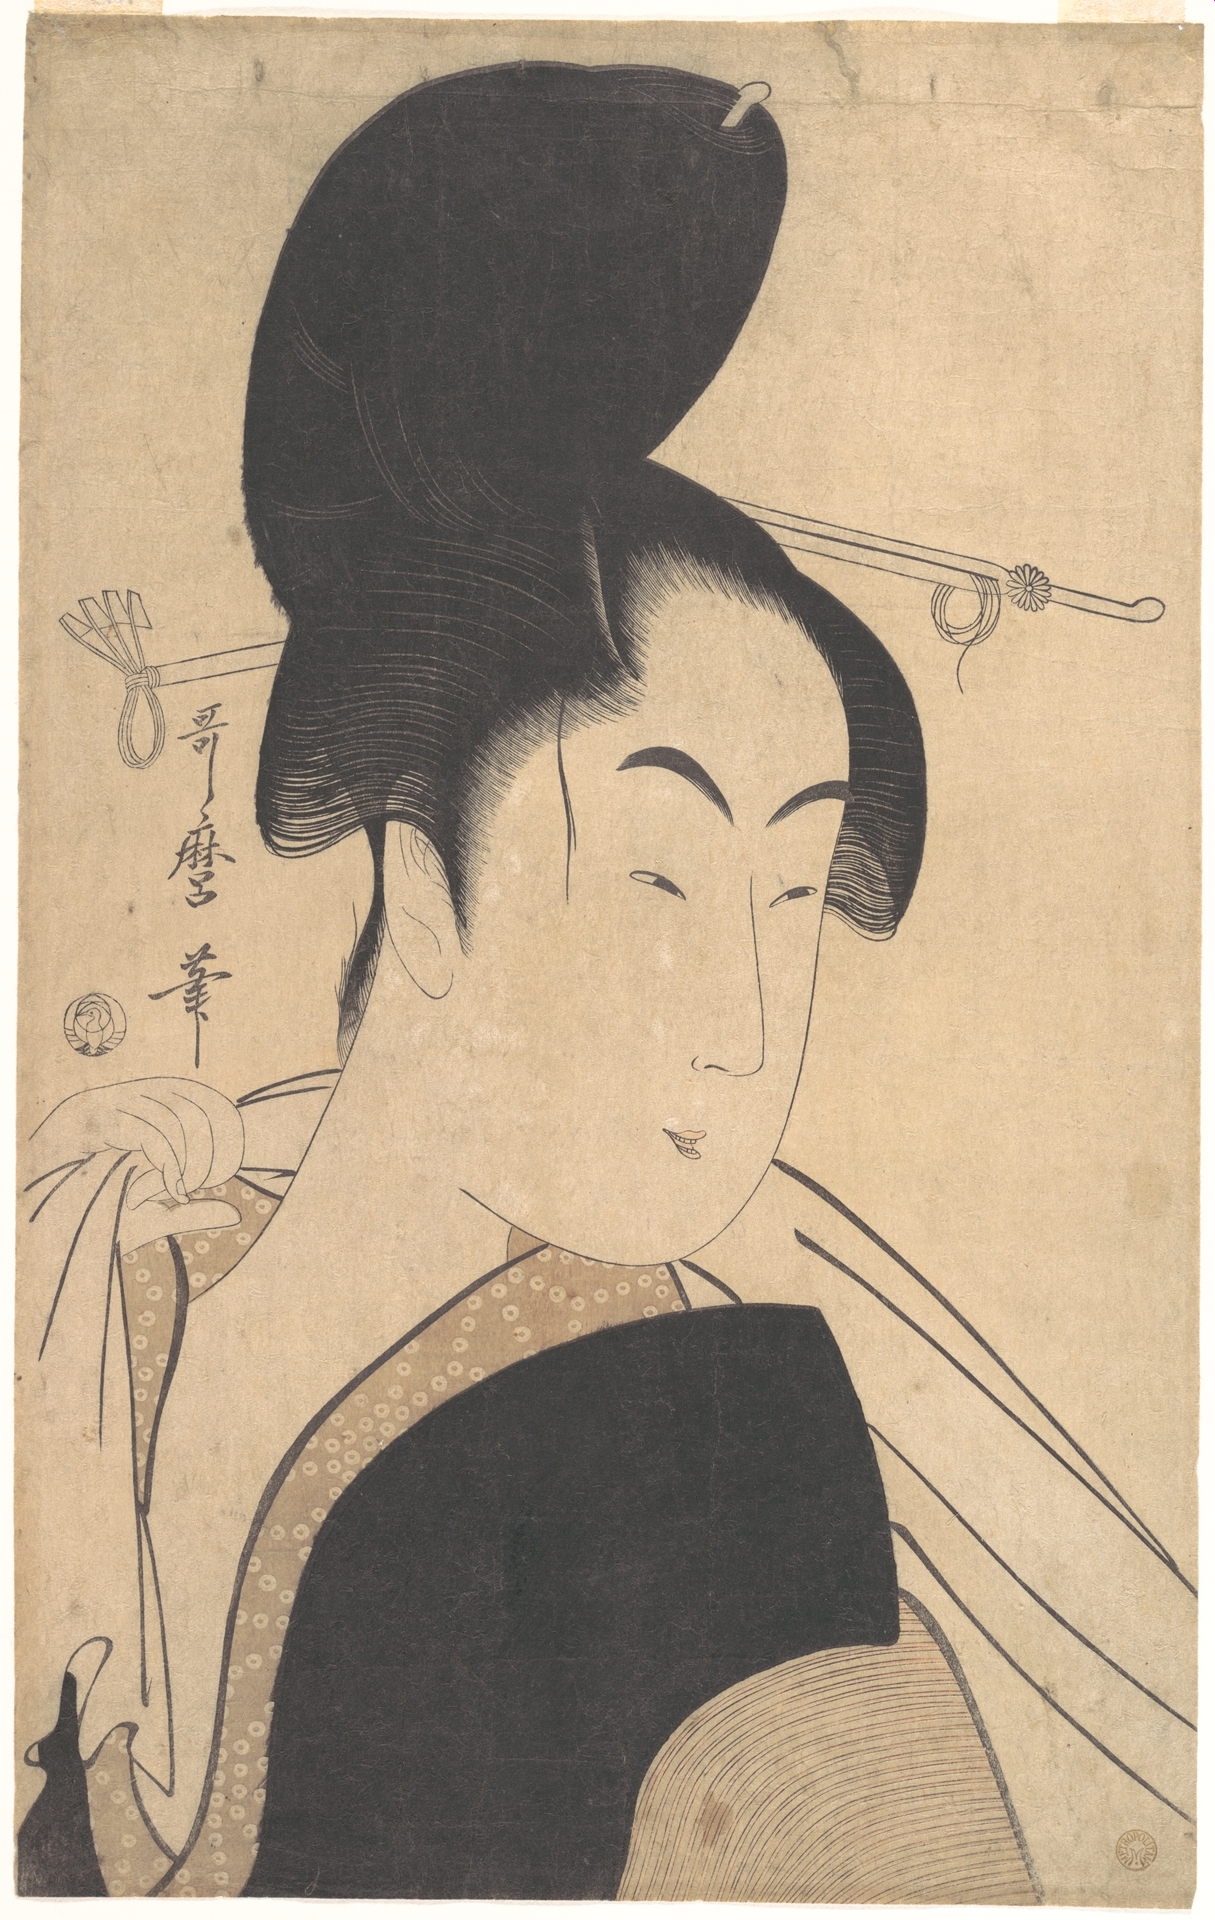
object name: print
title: Woman after a Bath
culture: japanese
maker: kitagawa utamaro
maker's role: artist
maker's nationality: japanese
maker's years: 1754-1806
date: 1795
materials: ink, paper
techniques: woodblock print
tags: women